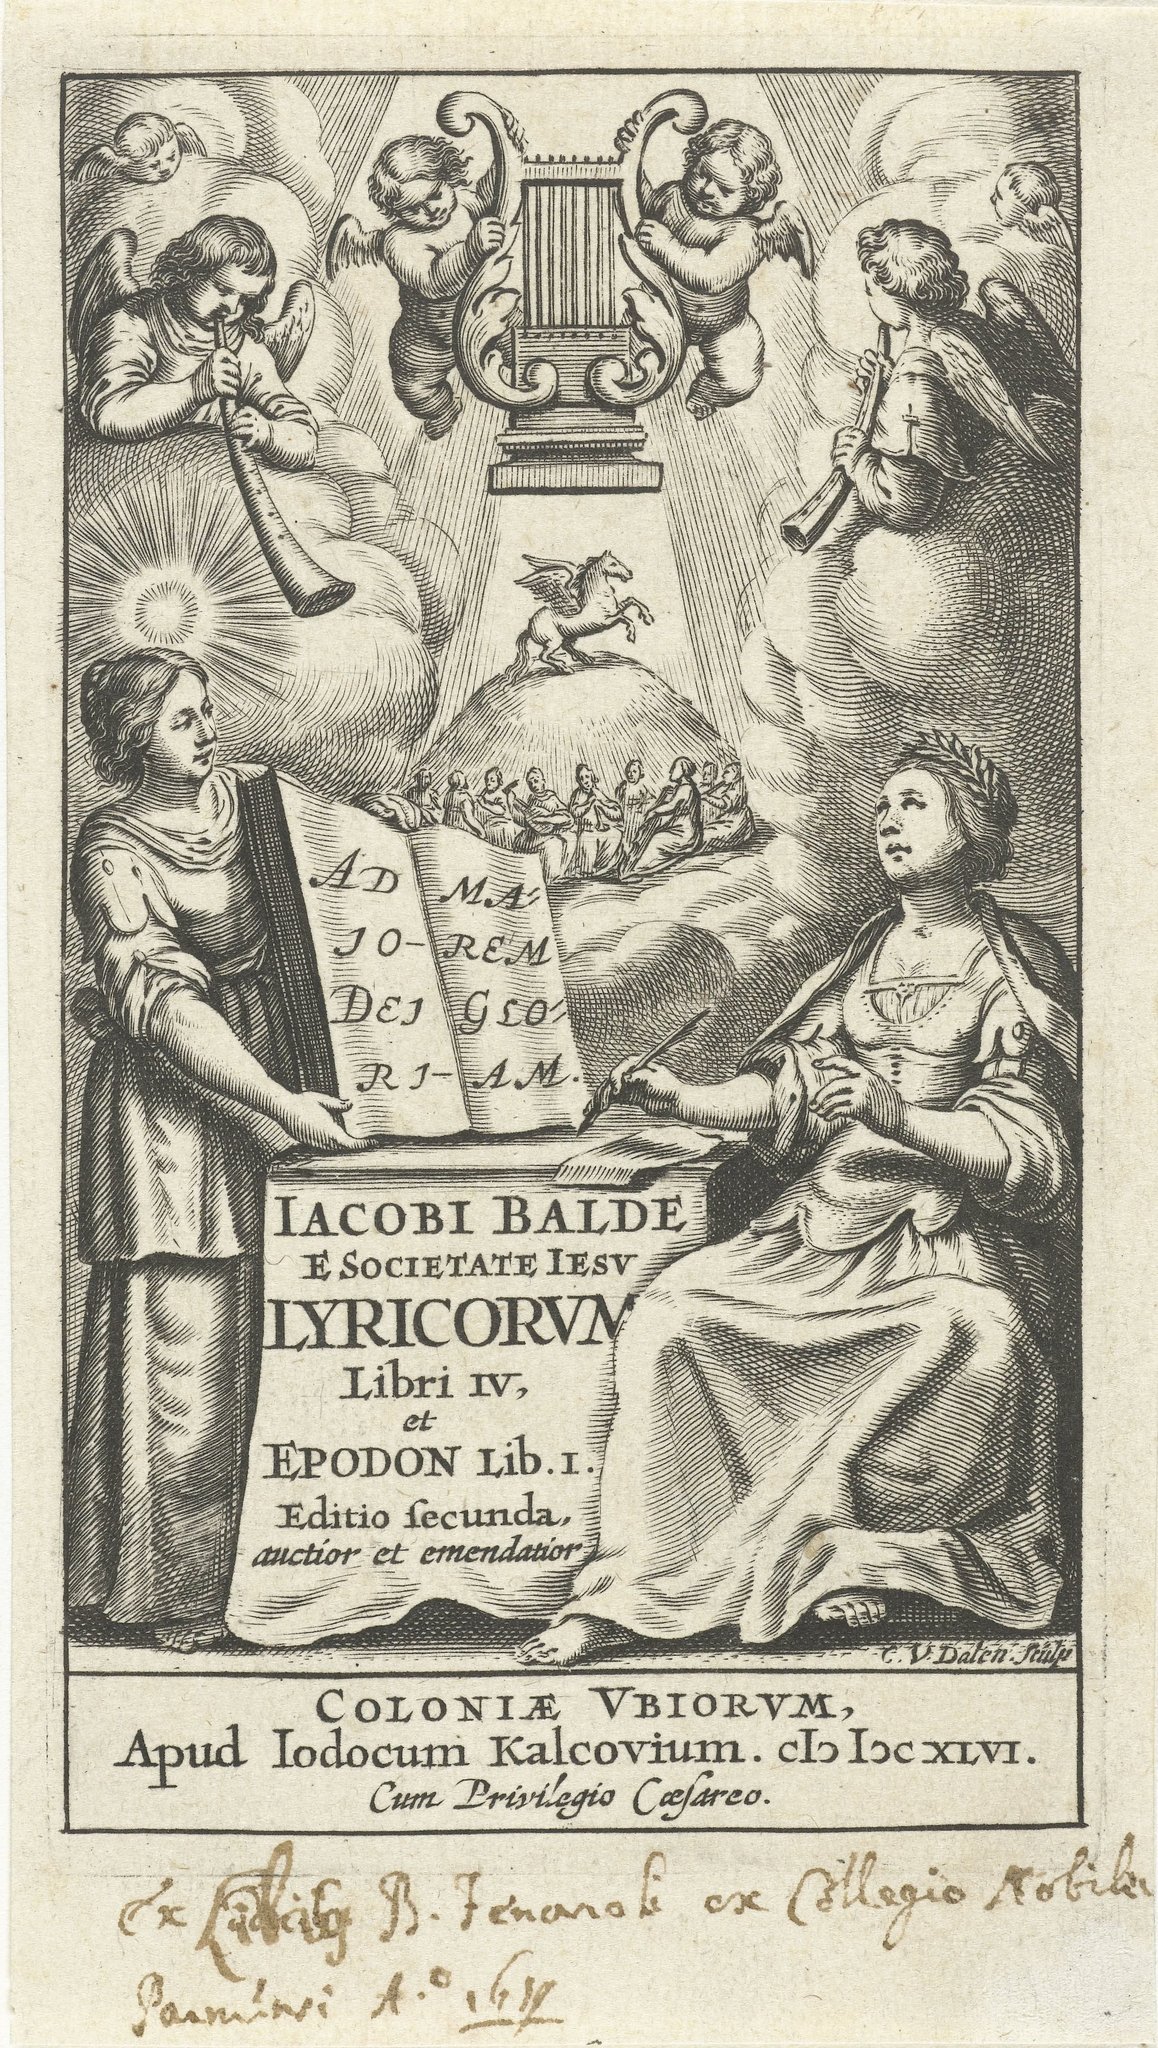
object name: print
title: Titelpagina voor: Lyricorum libri IV, Keulen 1646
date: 1646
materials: paper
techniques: engraving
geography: cologne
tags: angels singing, making music, (story of the) muses; 'muse' (ripa)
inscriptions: collector's mark: Lugt 2228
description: Titelpagina voor: Jacobus Balde, Lyricorum libri IV, Jost Kalckhoven (uitgever), Keulen 1646